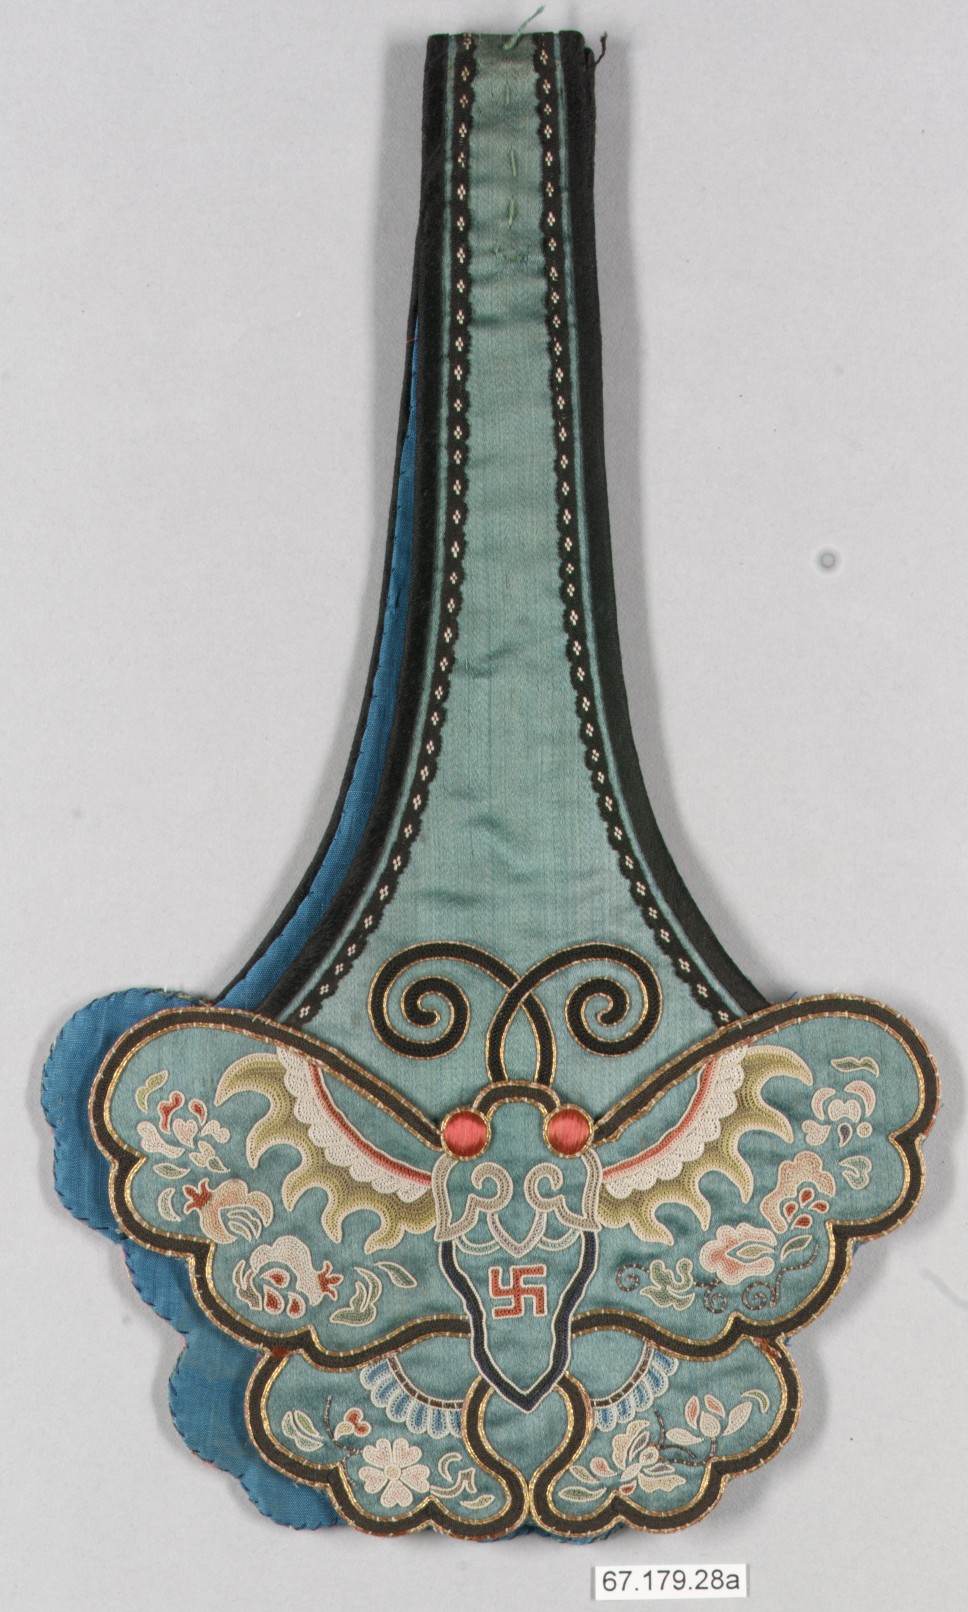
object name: appendage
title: Appendages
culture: chinese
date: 1801-1900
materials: metal thread, silk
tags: butterflies,flowers